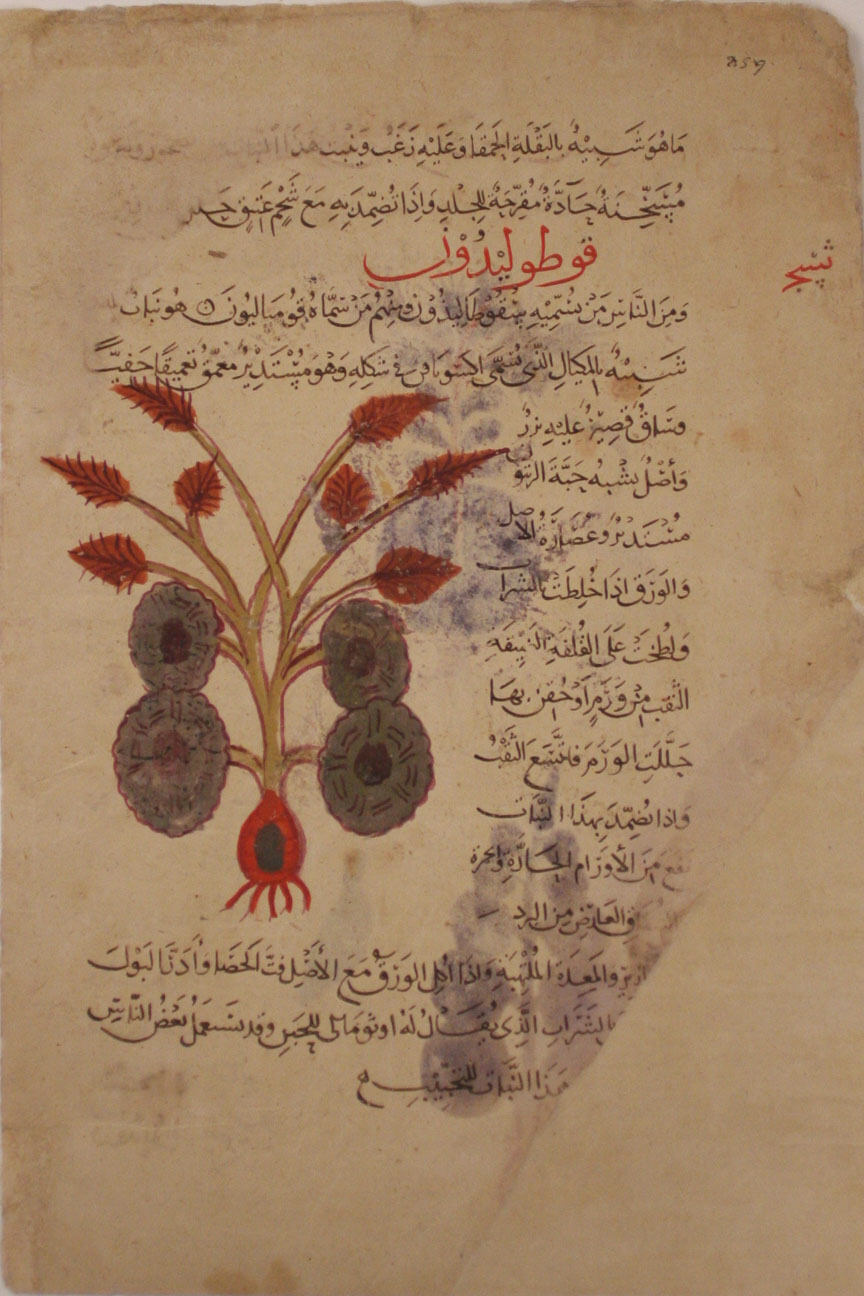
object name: folio from an illustrated manuscript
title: Folio from a Materia Medica of Dioscorides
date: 1201-1300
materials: paper, watercolor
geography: iraq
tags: birds,arabic,plants,calligraphy